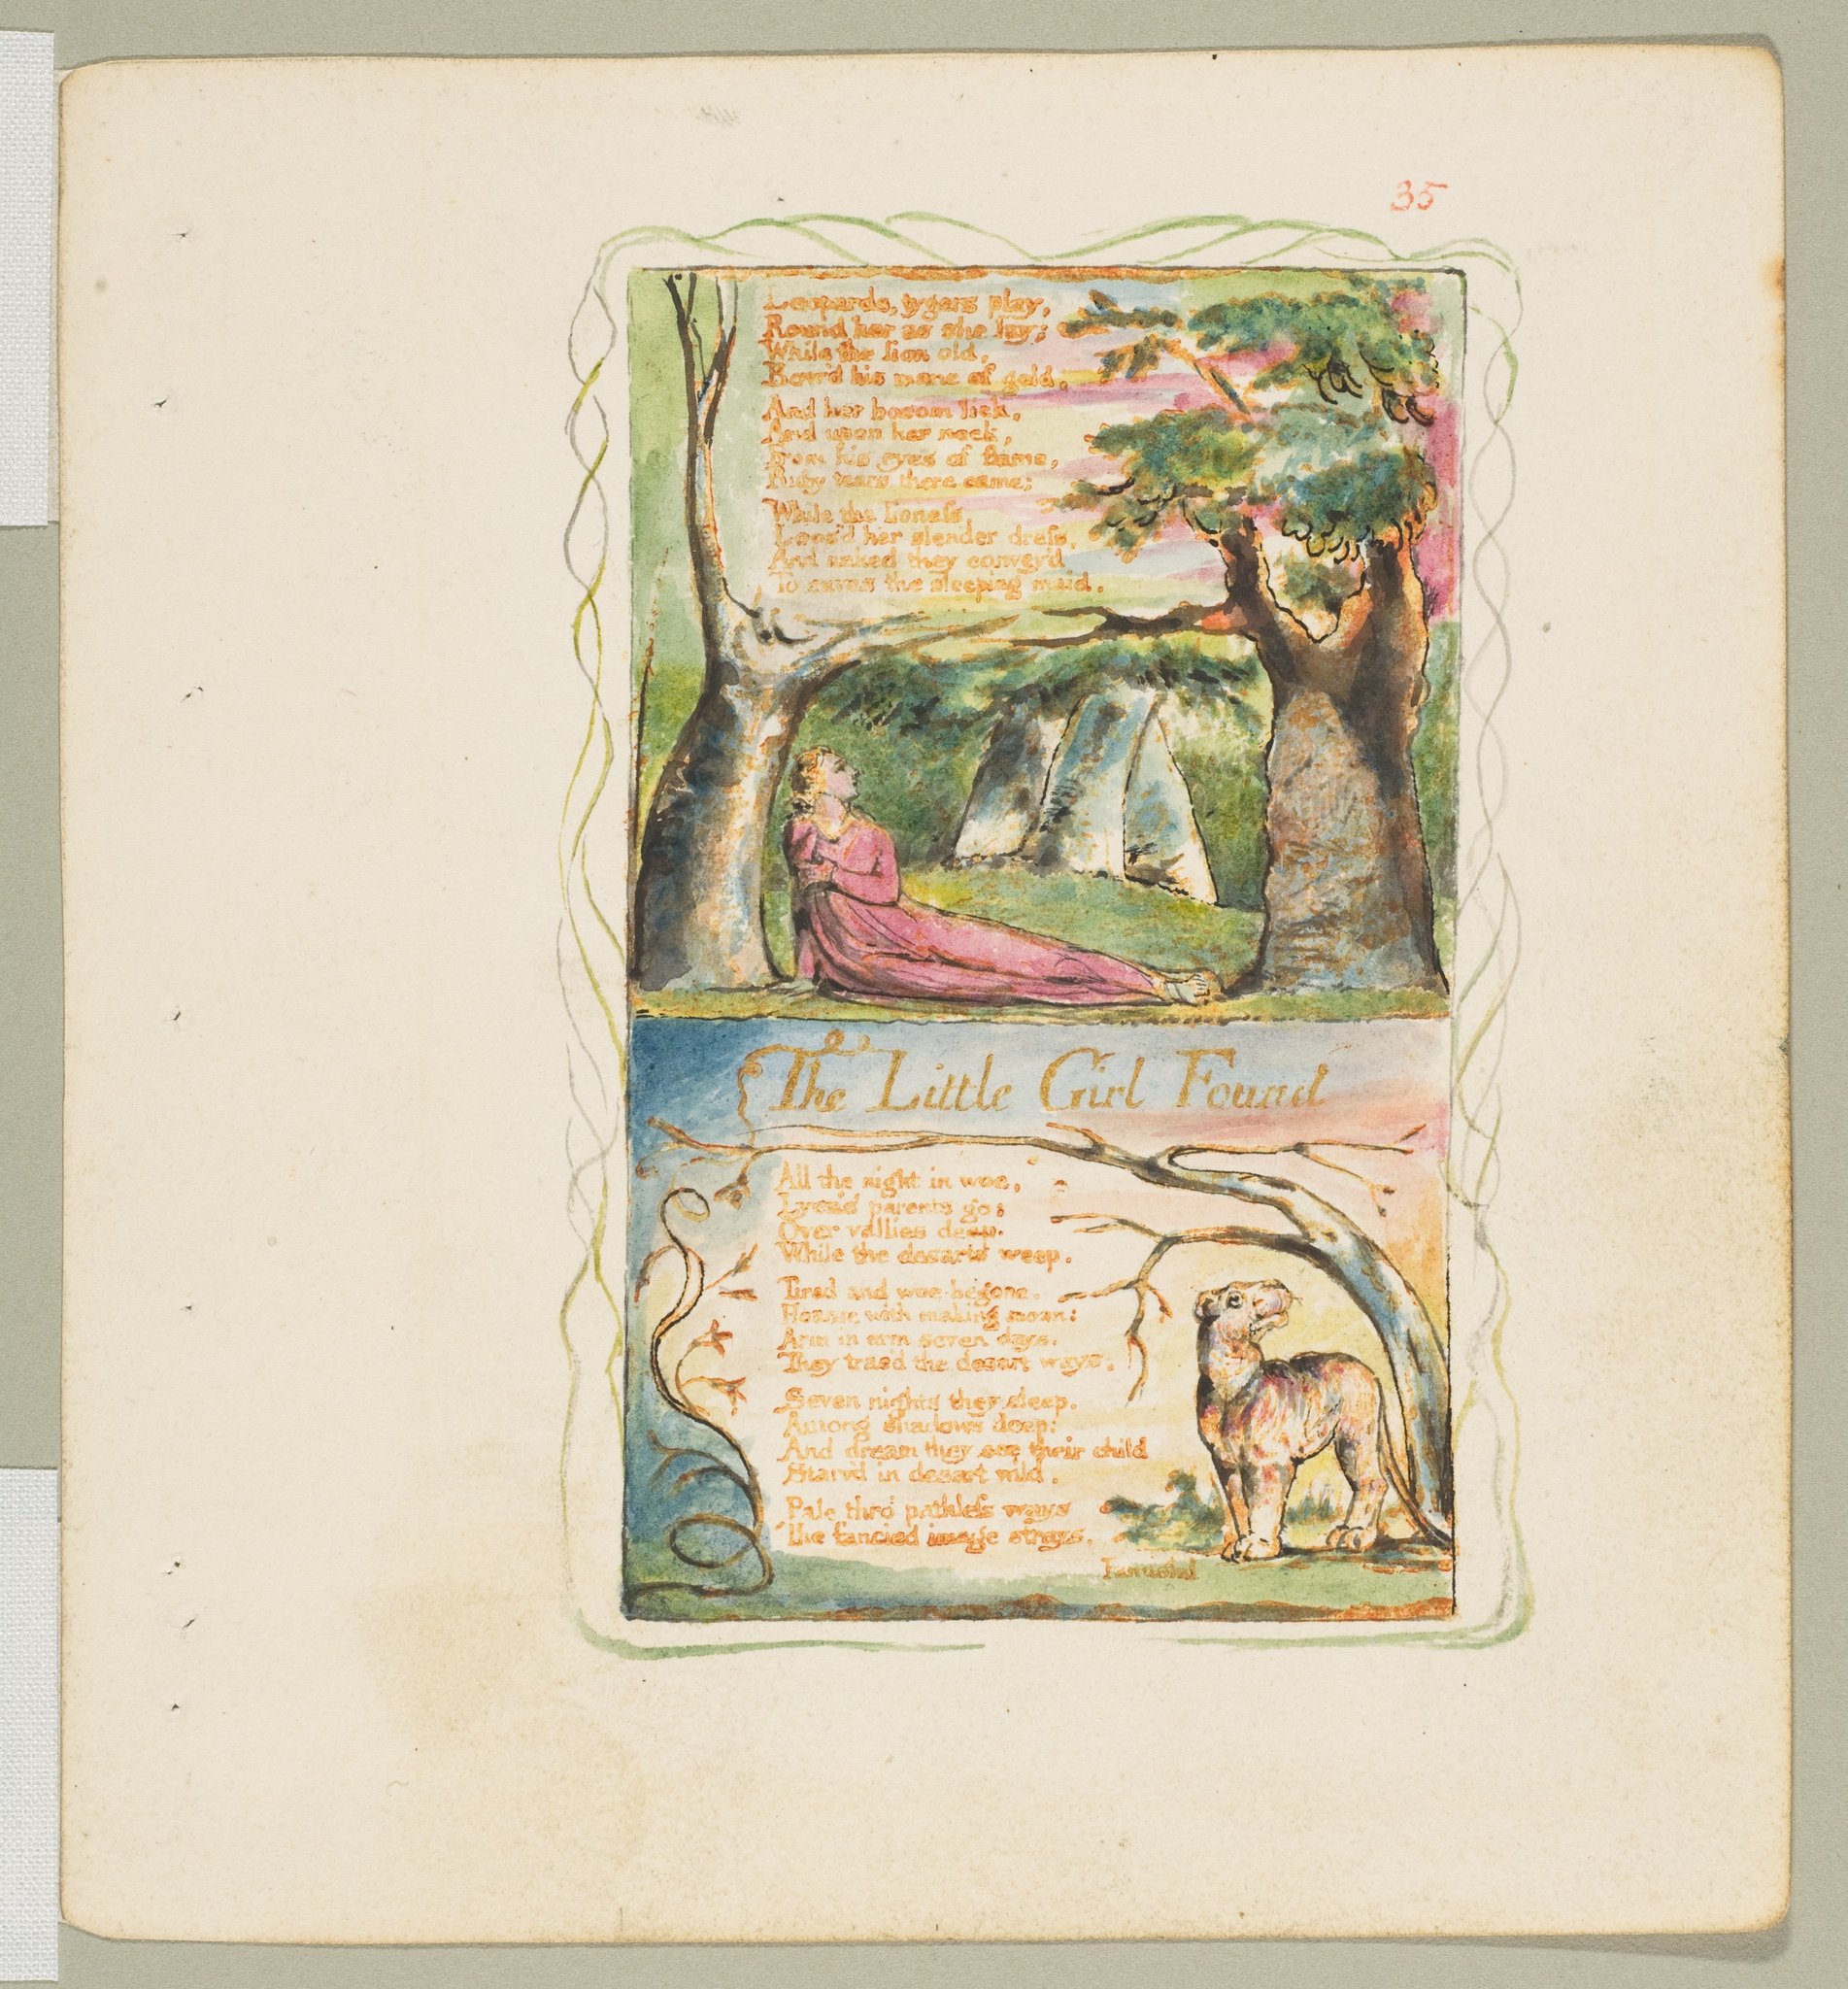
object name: print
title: Songs of Experience: The Little Girl Lost (second plate); The Little Girl Found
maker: william blake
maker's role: artist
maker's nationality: british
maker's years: 1757-1827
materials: gold, ink, shell, watercolor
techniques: etching, hand coloring, printing, relief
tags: animals,poetry,girls,trees